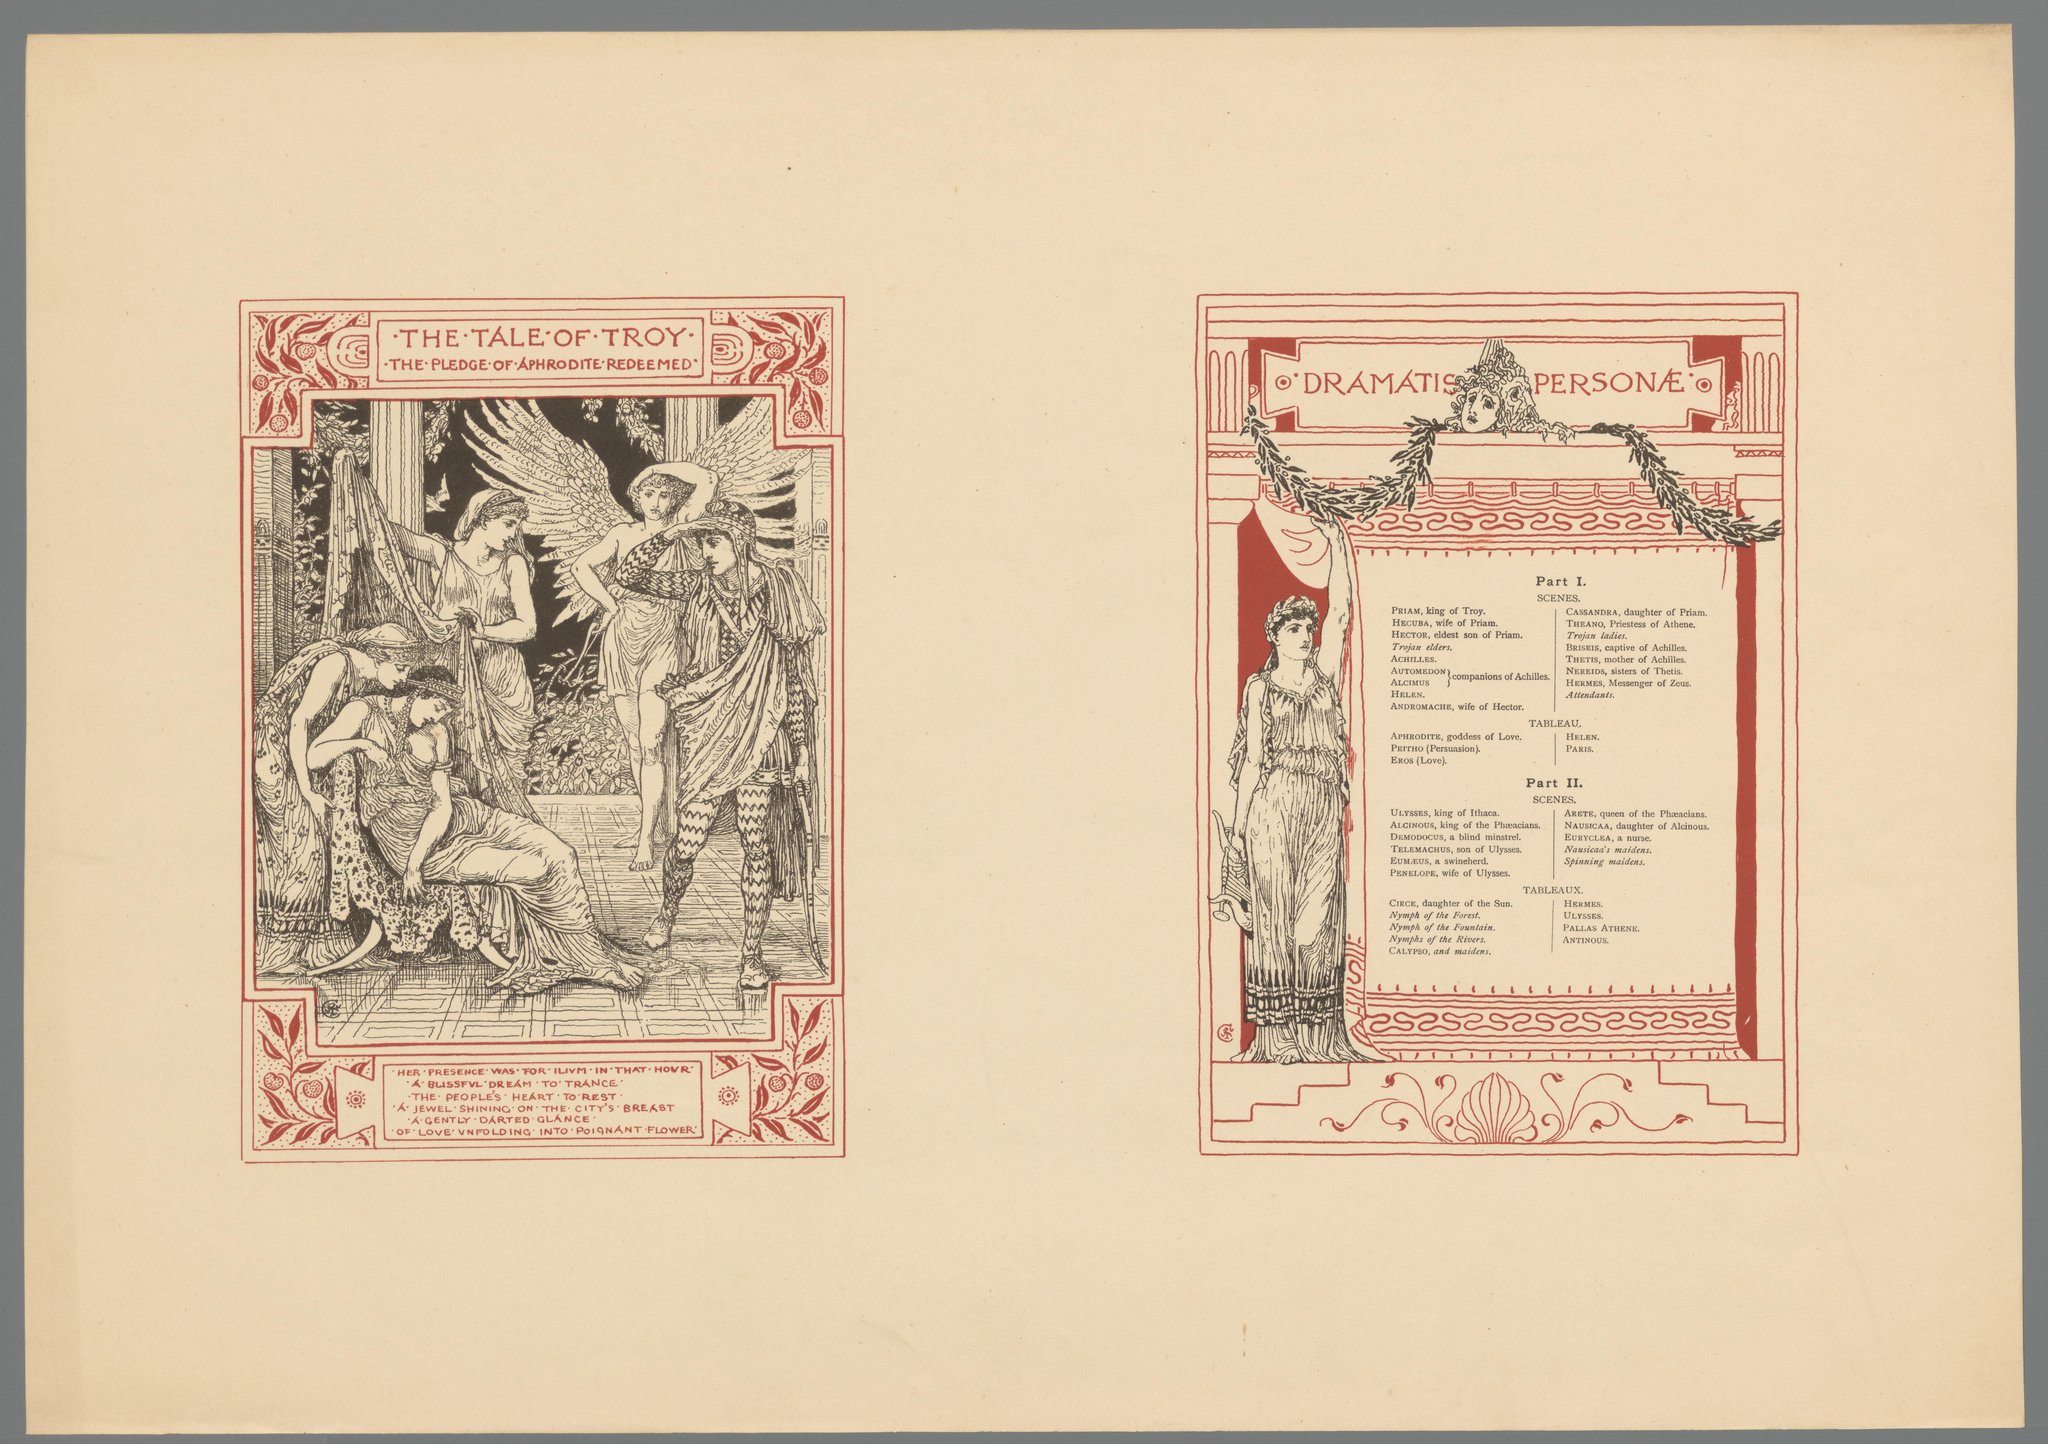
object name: book illustration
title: Helena wordt gepresenteerd aan Paris en een cartouche met figuur bij een gordijn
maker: walter crane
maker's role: draughtsman, print maker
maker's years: 1845-1915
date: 1887-1888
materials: paper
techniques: letterpress printing, lithograph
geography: london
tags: curtain ~ stage, venus fetches helen and brings her to paris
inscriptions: collector's mark: Lugt 2228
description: Prent uit: Warr, George C. Echoes of Hellas: the tale of Troy & the story of Orestes from Homer & Aeschylus. Londen: Marcus Ward & Company, [1887/1888].